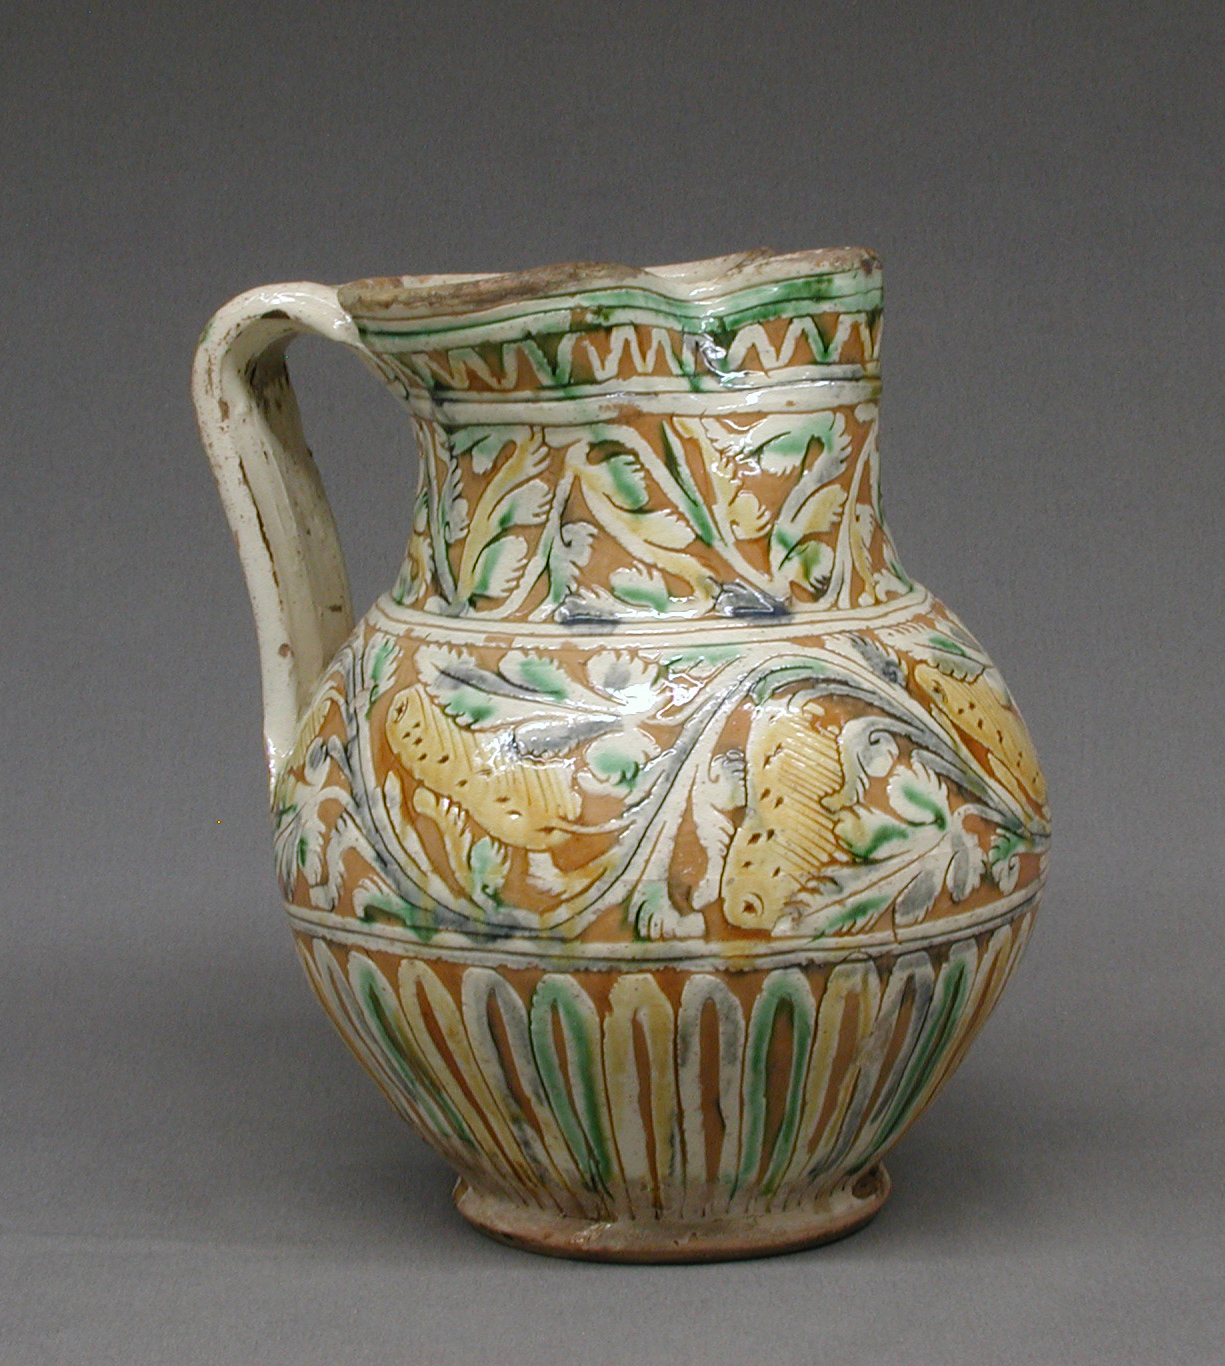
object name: jug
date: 1501-1700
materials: earthenware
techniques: glazing